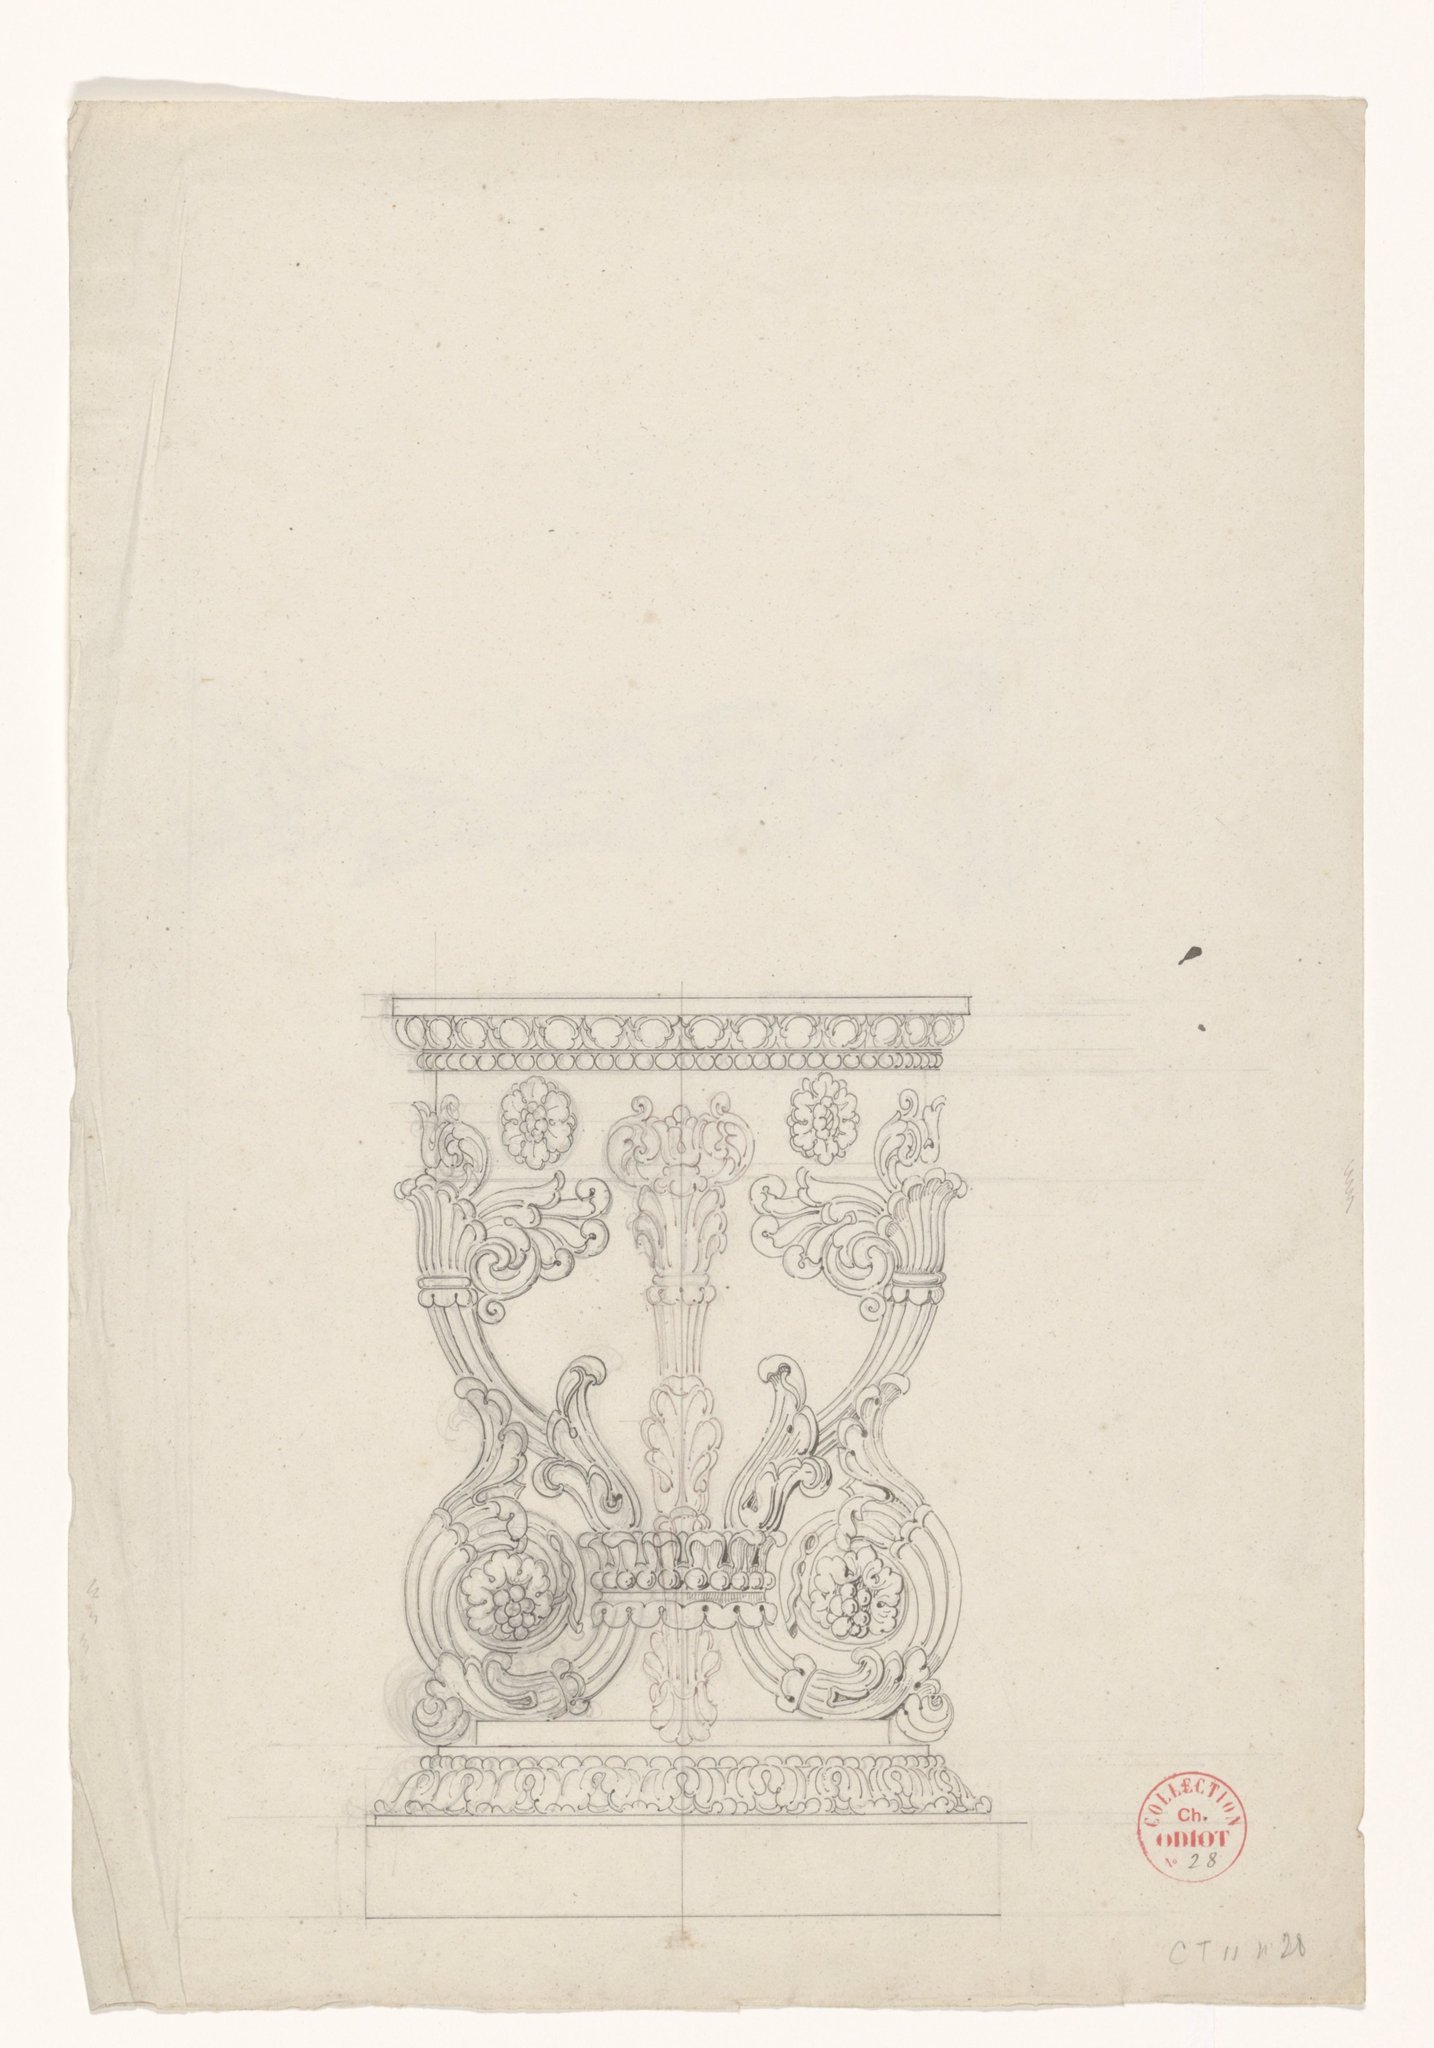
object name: design drawing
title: Ontwerp voor een lage ronde schaal of voet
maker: charles nicolas odiot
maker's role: jeweler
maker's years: 1789-1869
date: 1825-1830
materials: ink, paper, pencil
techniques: drawing, pen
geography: paris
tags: containers, pedestal of a piece of sculpture (perhaps in the form of a herm)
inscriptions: inscription: ‘CT 11 No 28’, stamp